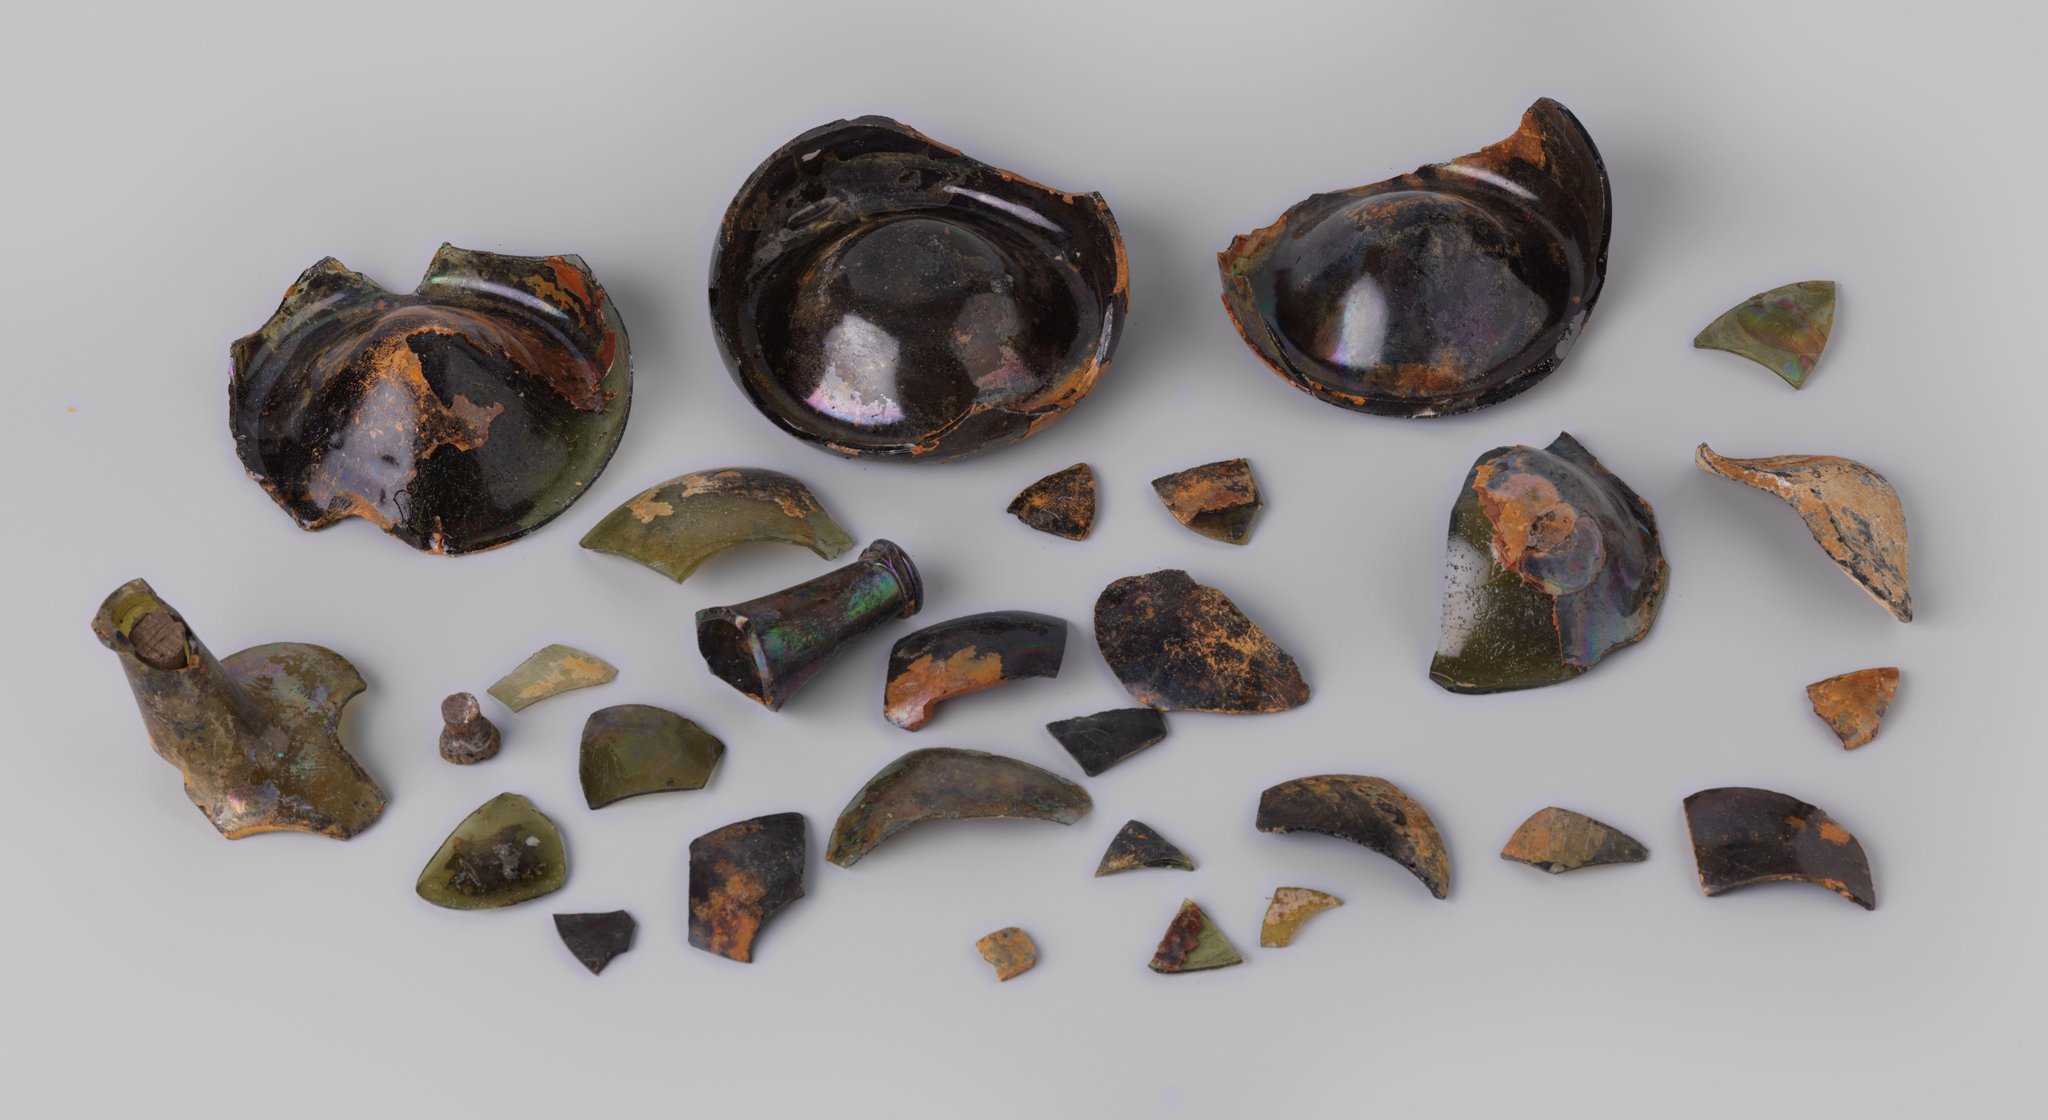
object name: wine bottle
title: Scherven van wijnflessen uit het wrak van de Oost-Indiëvaarder 't Vliegend Hart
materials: cork, glass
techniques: green glass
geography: netherlands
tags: 't vliegend hart (schip), verenigde oostindische compagnie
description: Scherven van uivormige wijnflessen van groen glas waar rode (port)wijn in heeft gezeten. Halzen met kurk.